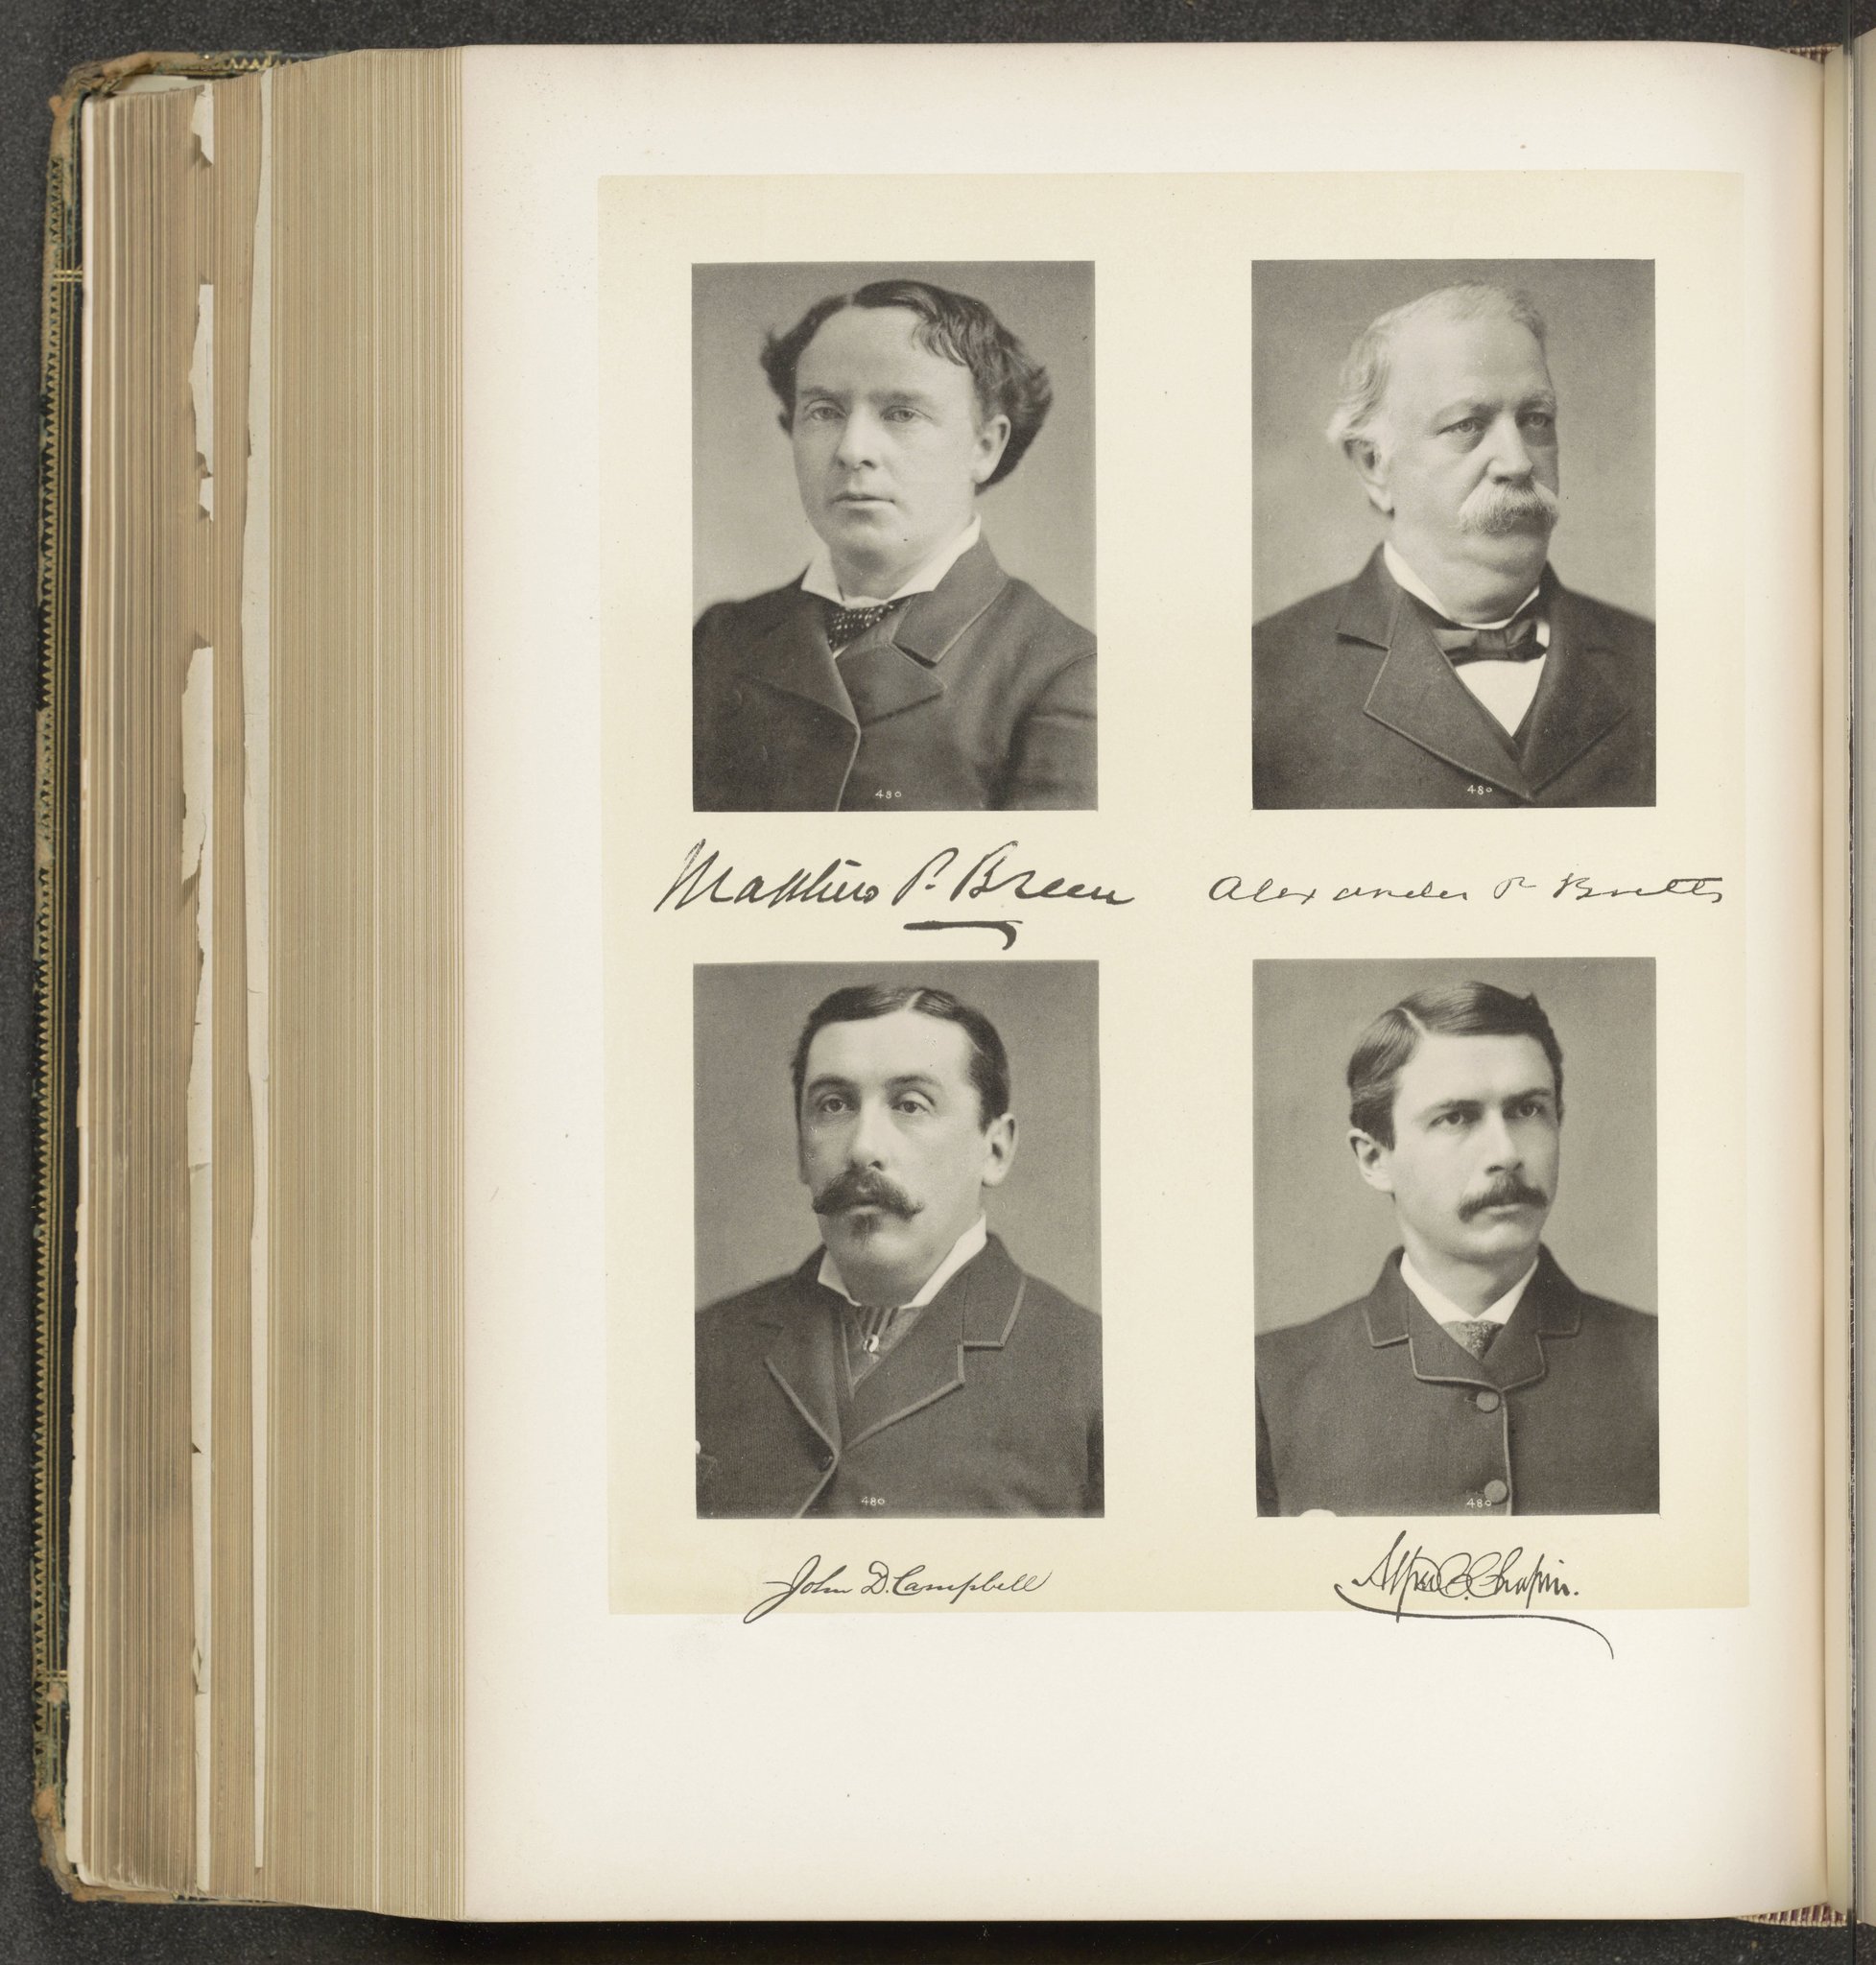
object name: page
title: Portretten van vier leden van het Lagerhuis van de staat New York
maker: Anonymous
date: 1872-1882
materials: paper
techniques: photograph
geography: united states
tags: historical persons (portraits and scenes from the life) (+ head (and shoulders) (portrait))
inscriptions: annotation, number: ‘480’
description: Linksboven Matthew P. Breen, rechtsboven Alexander P. Butts, linksonder John D. Campbell, rechtsonder Alfred C. Chapin.